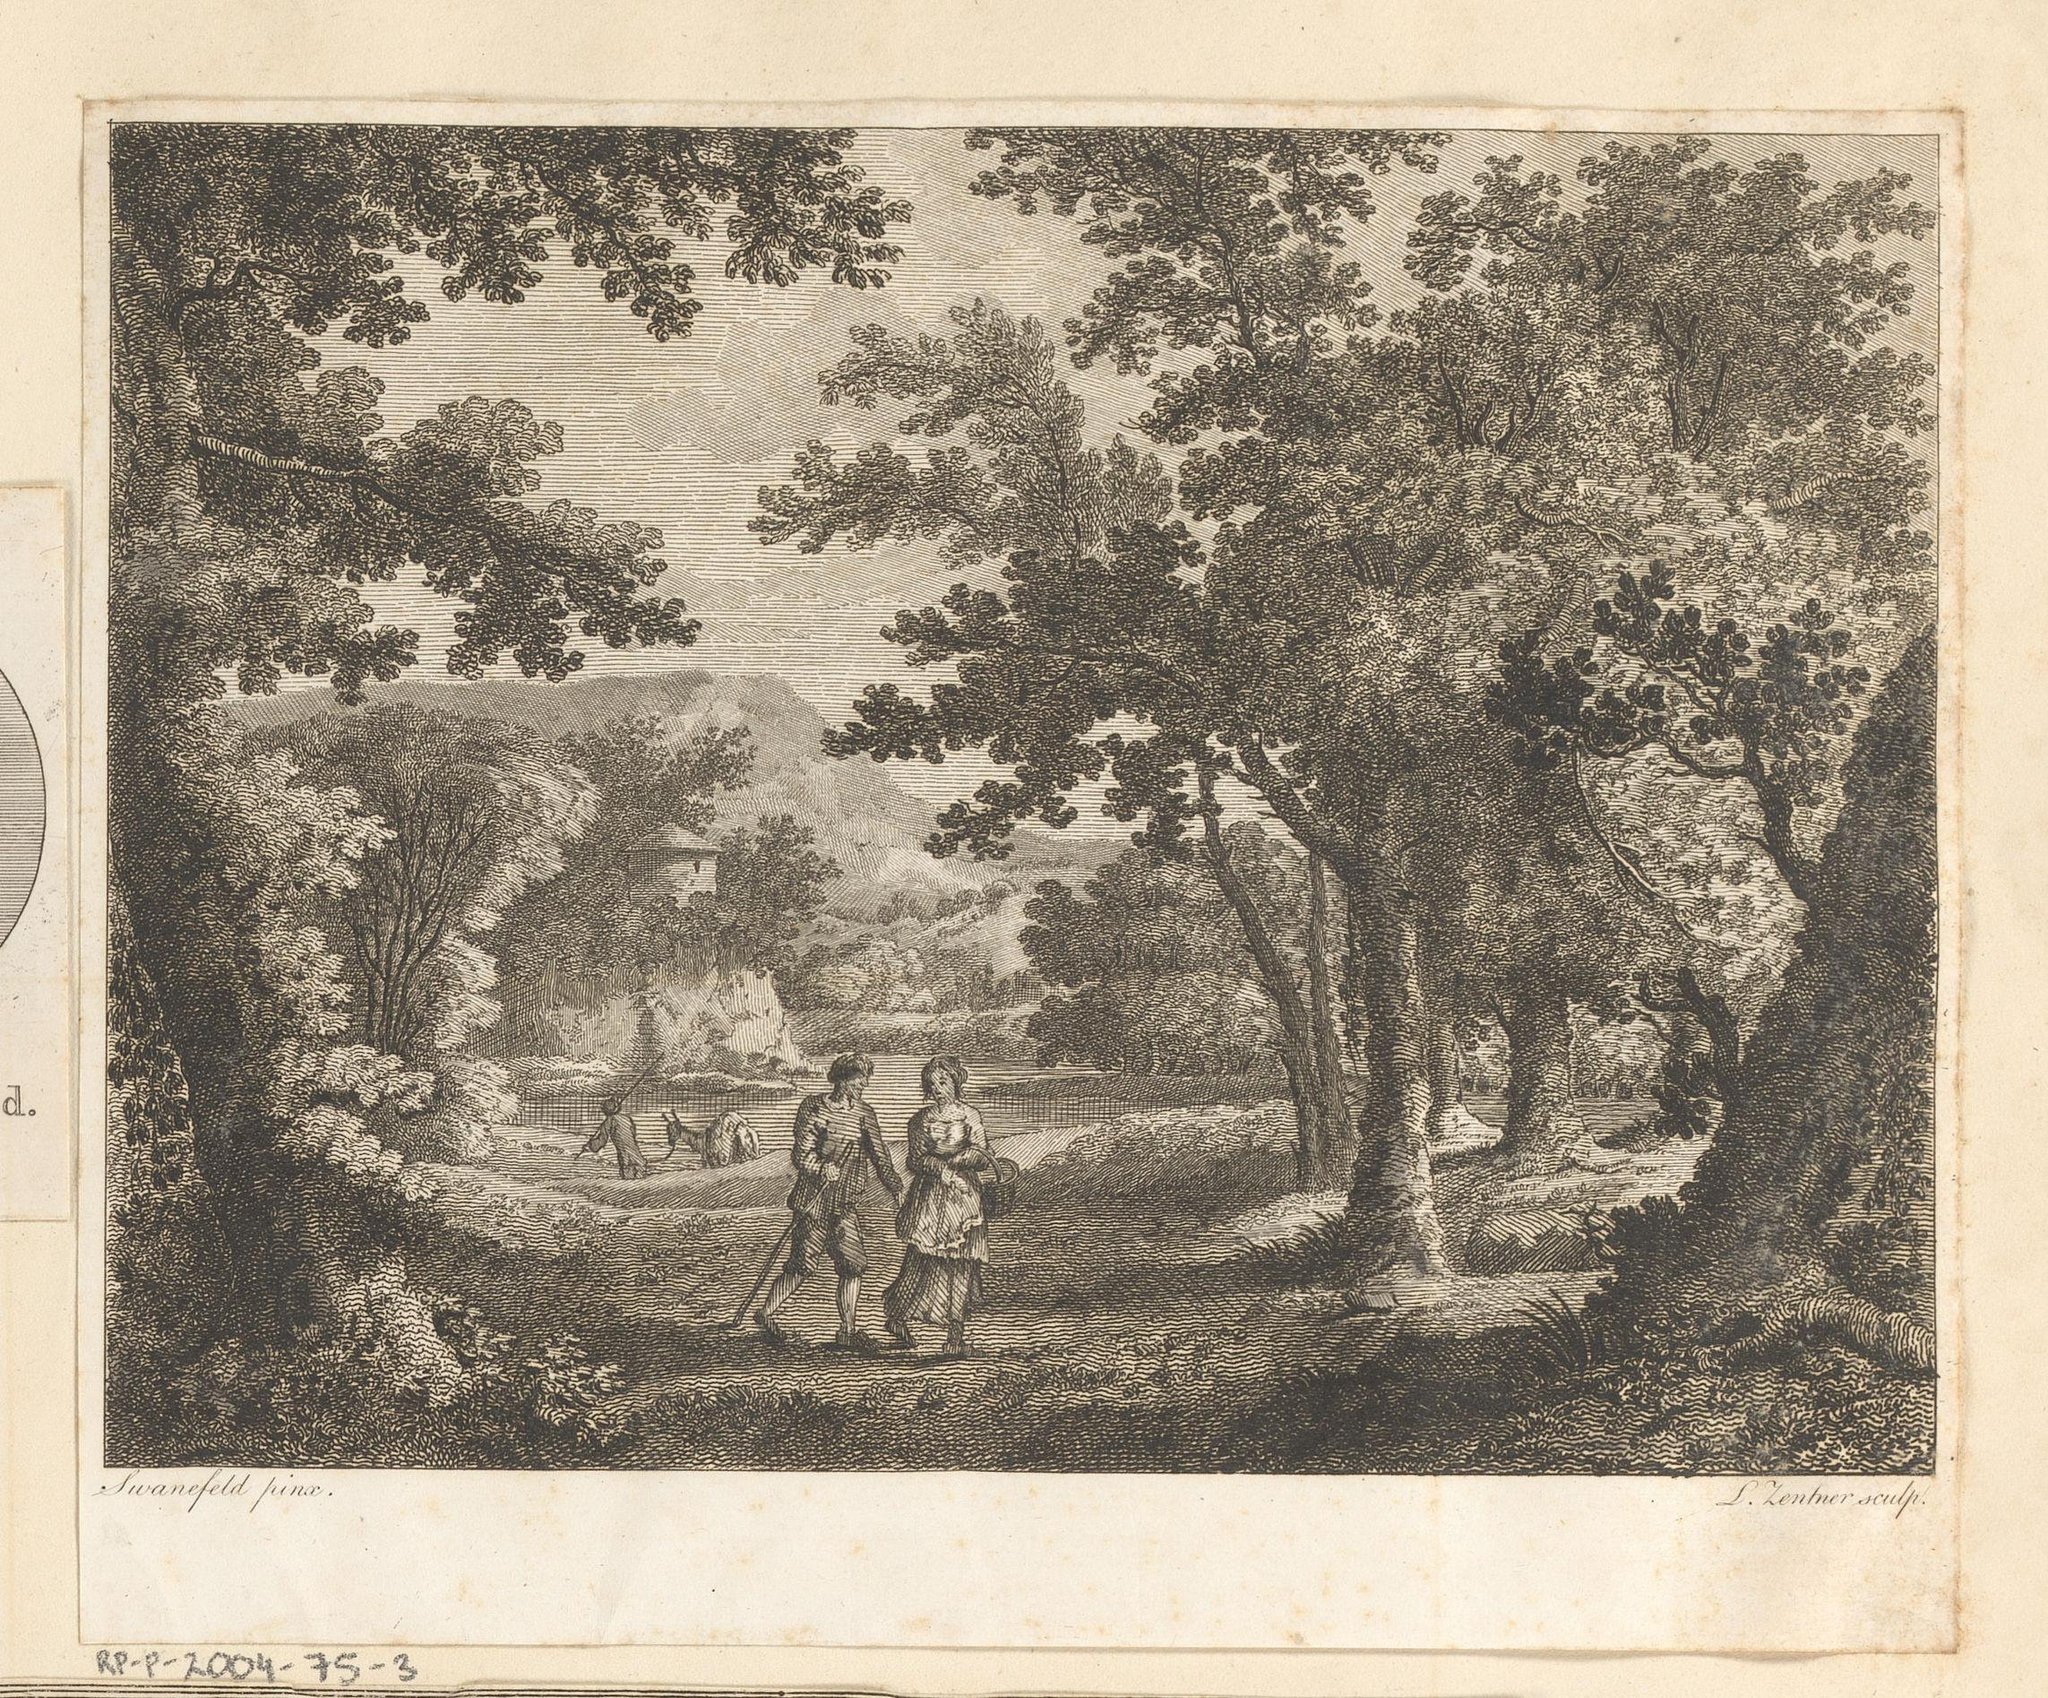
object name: album leaf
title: Landschap met wandelaars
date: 1791-1798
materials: paper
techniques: engraving, etching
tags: forest, wood (+ landscape with figures, staffage)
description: Prent uit: Zentner, J.L.L.C.. A select Collection of landscapes, from the best old masters, one of each engraved by L. Zentner, after drawings made by him from original pictures (...). Londen: J. Thane, [1791-1798]. De samensteller heeft deze prent in het album geplakt als illustratie bij: Pilkington, Matthew en Johann Heinrich Füssli. A dictionary of painters, from the revival of the art to the present period. 4 dln. Londen: John Crowder, 1805, dl. 4, p. 544.